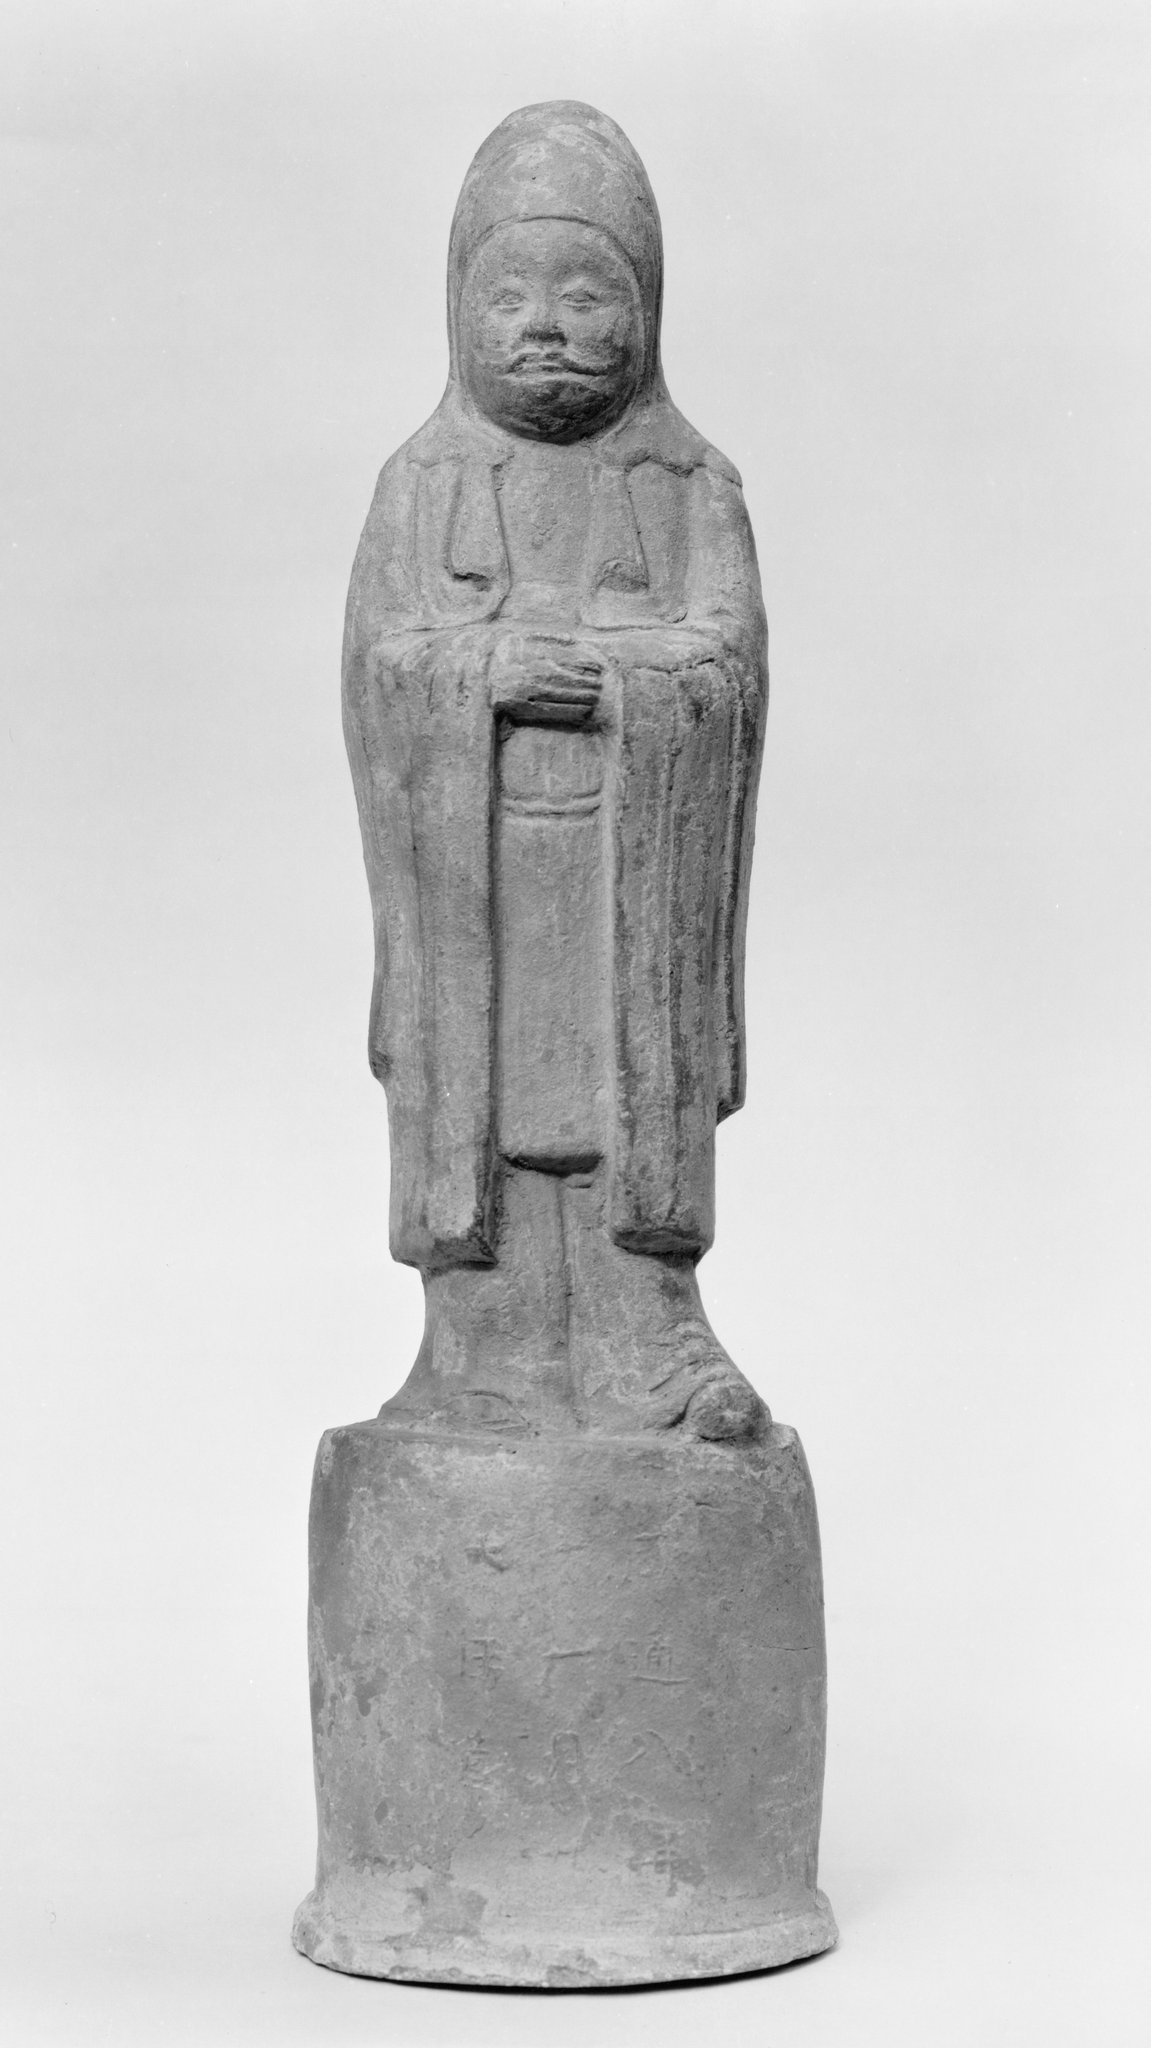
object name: statuette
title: Official Standing on High Base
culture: chinese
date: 801-900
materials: terracotta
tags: men